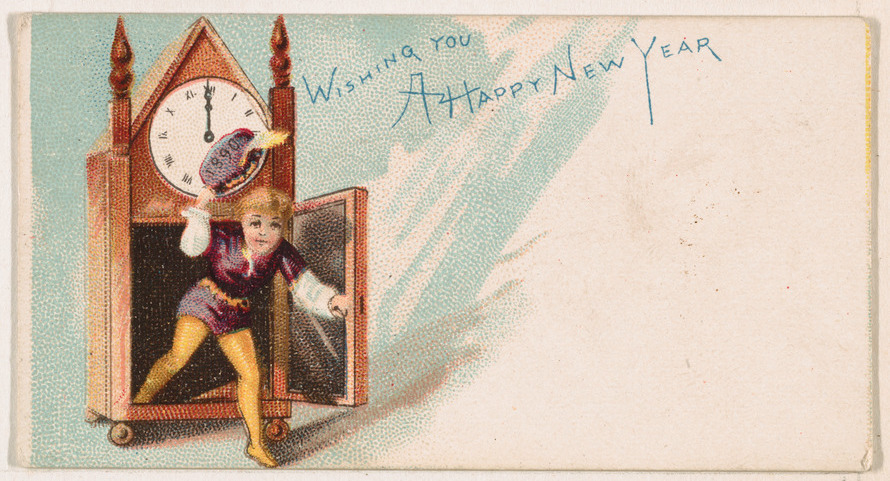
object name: print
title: Wishing You a Happy New Year, from the New Years 1890 series (N227) issued by Kinney Bros.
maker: kinney brothers tobacco company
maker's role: publisher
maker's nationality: american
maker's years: 1869-2011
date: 1889-1890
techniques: color lithograph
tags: boys,clocks